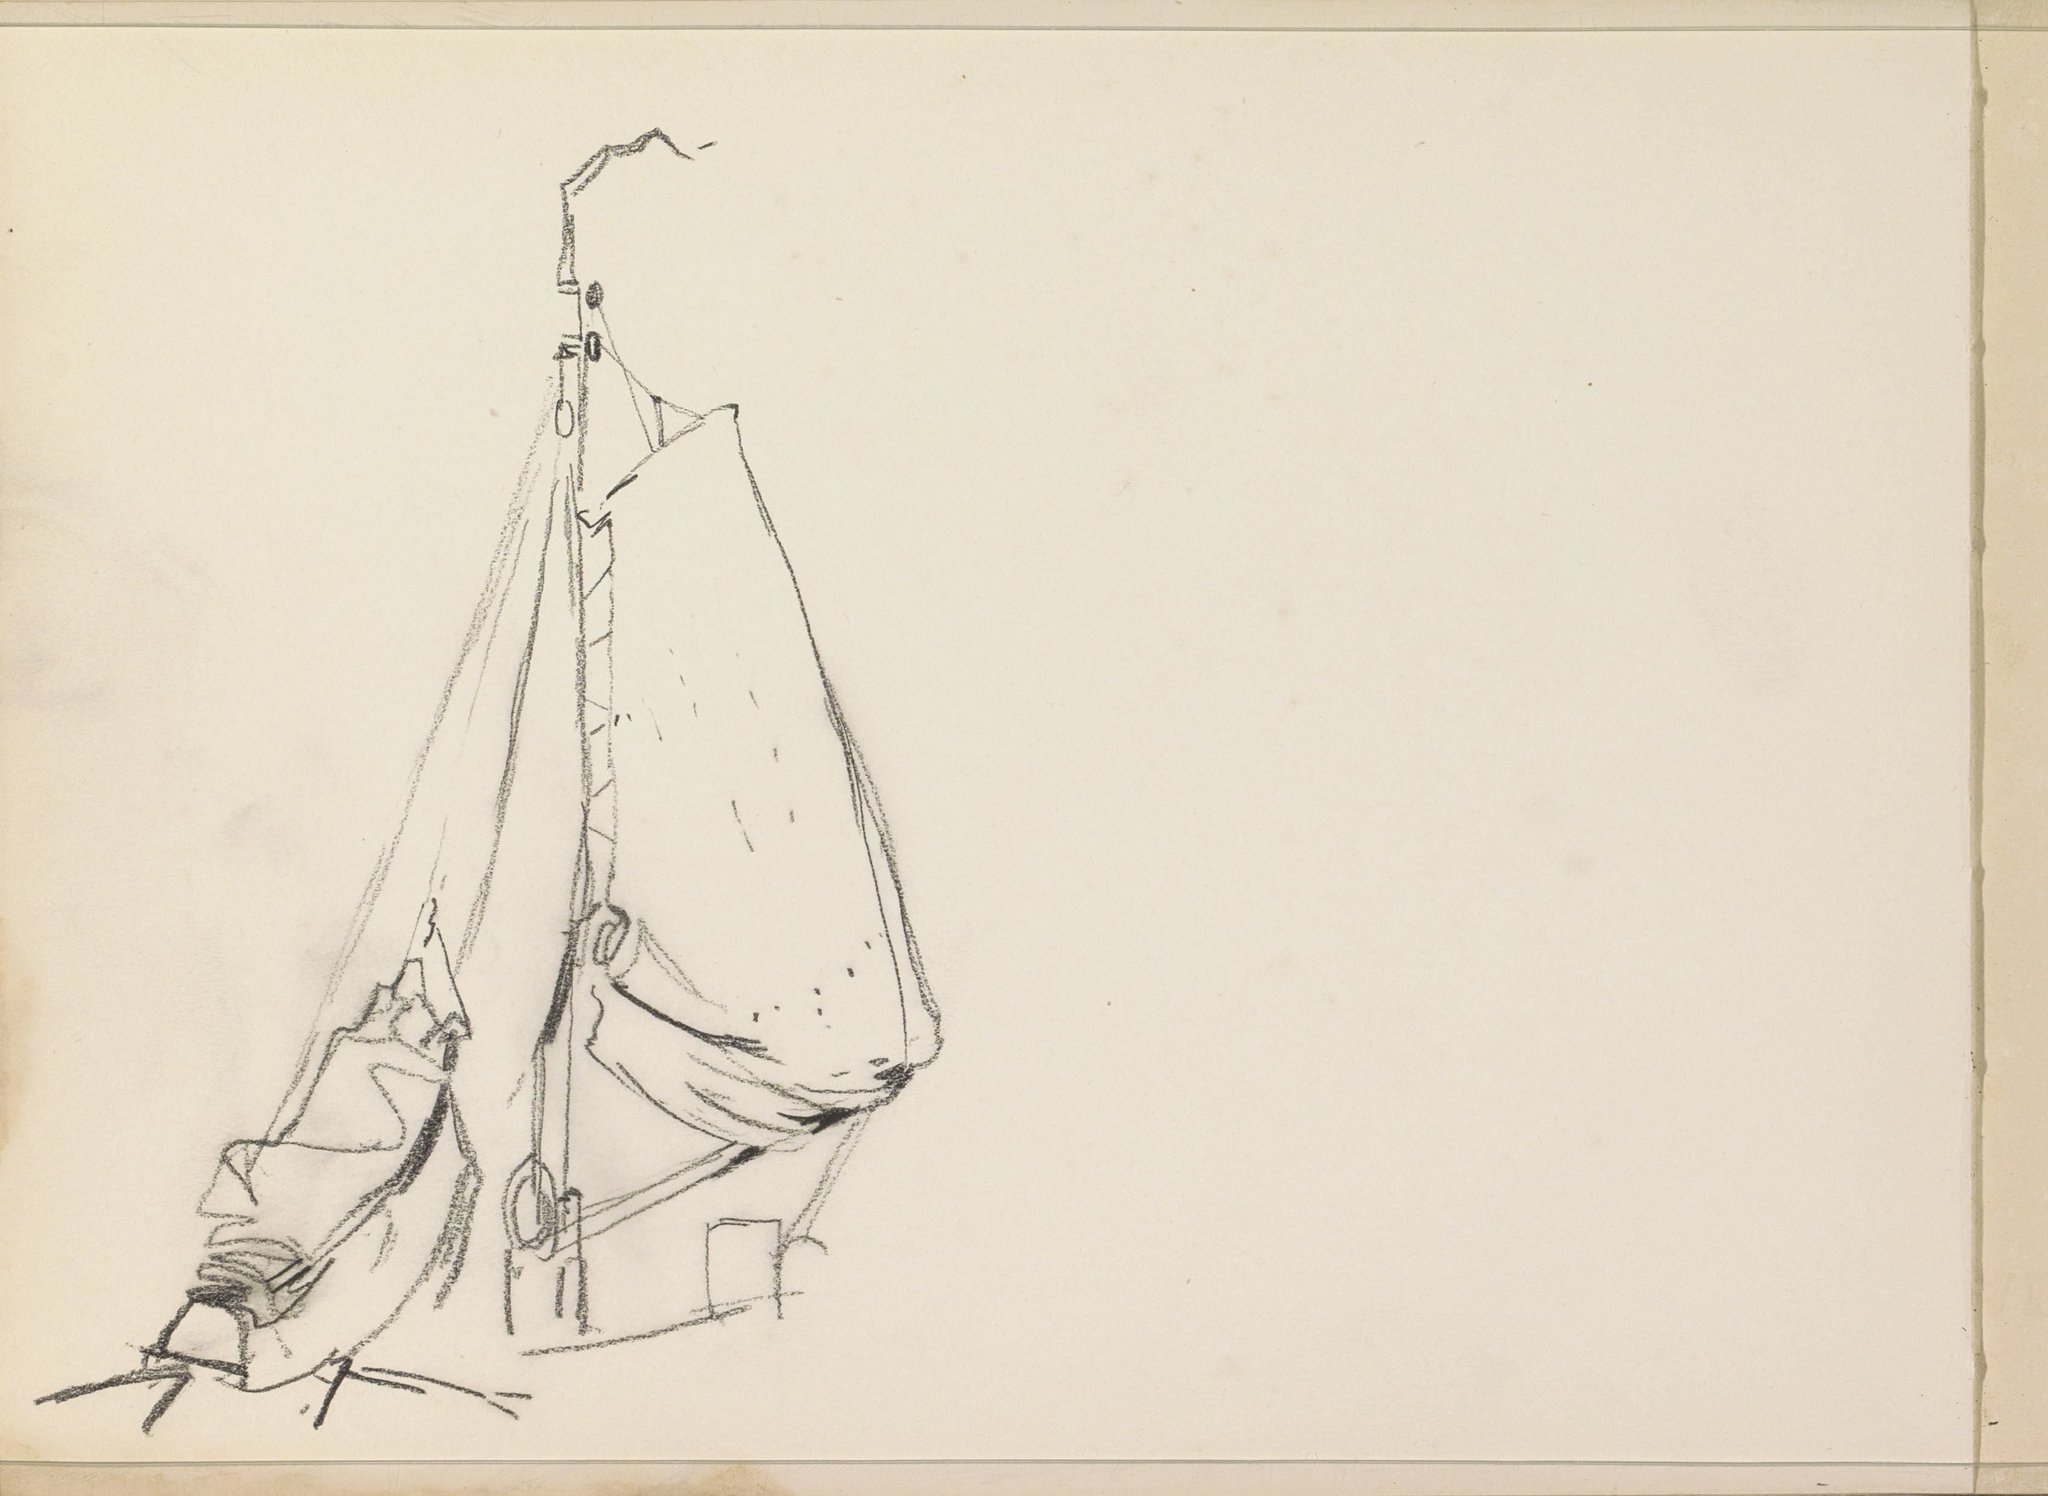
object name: sketchbook leaf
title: Zeilboot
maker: cornelis vreedenburgh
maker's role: draughtsman, print maker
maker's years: 1880-1946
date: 1890-1946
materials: chalk, paper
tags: sailing-ship, sailing-boat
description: Blad 4 verso uit een schetsboek met 24 bladen.